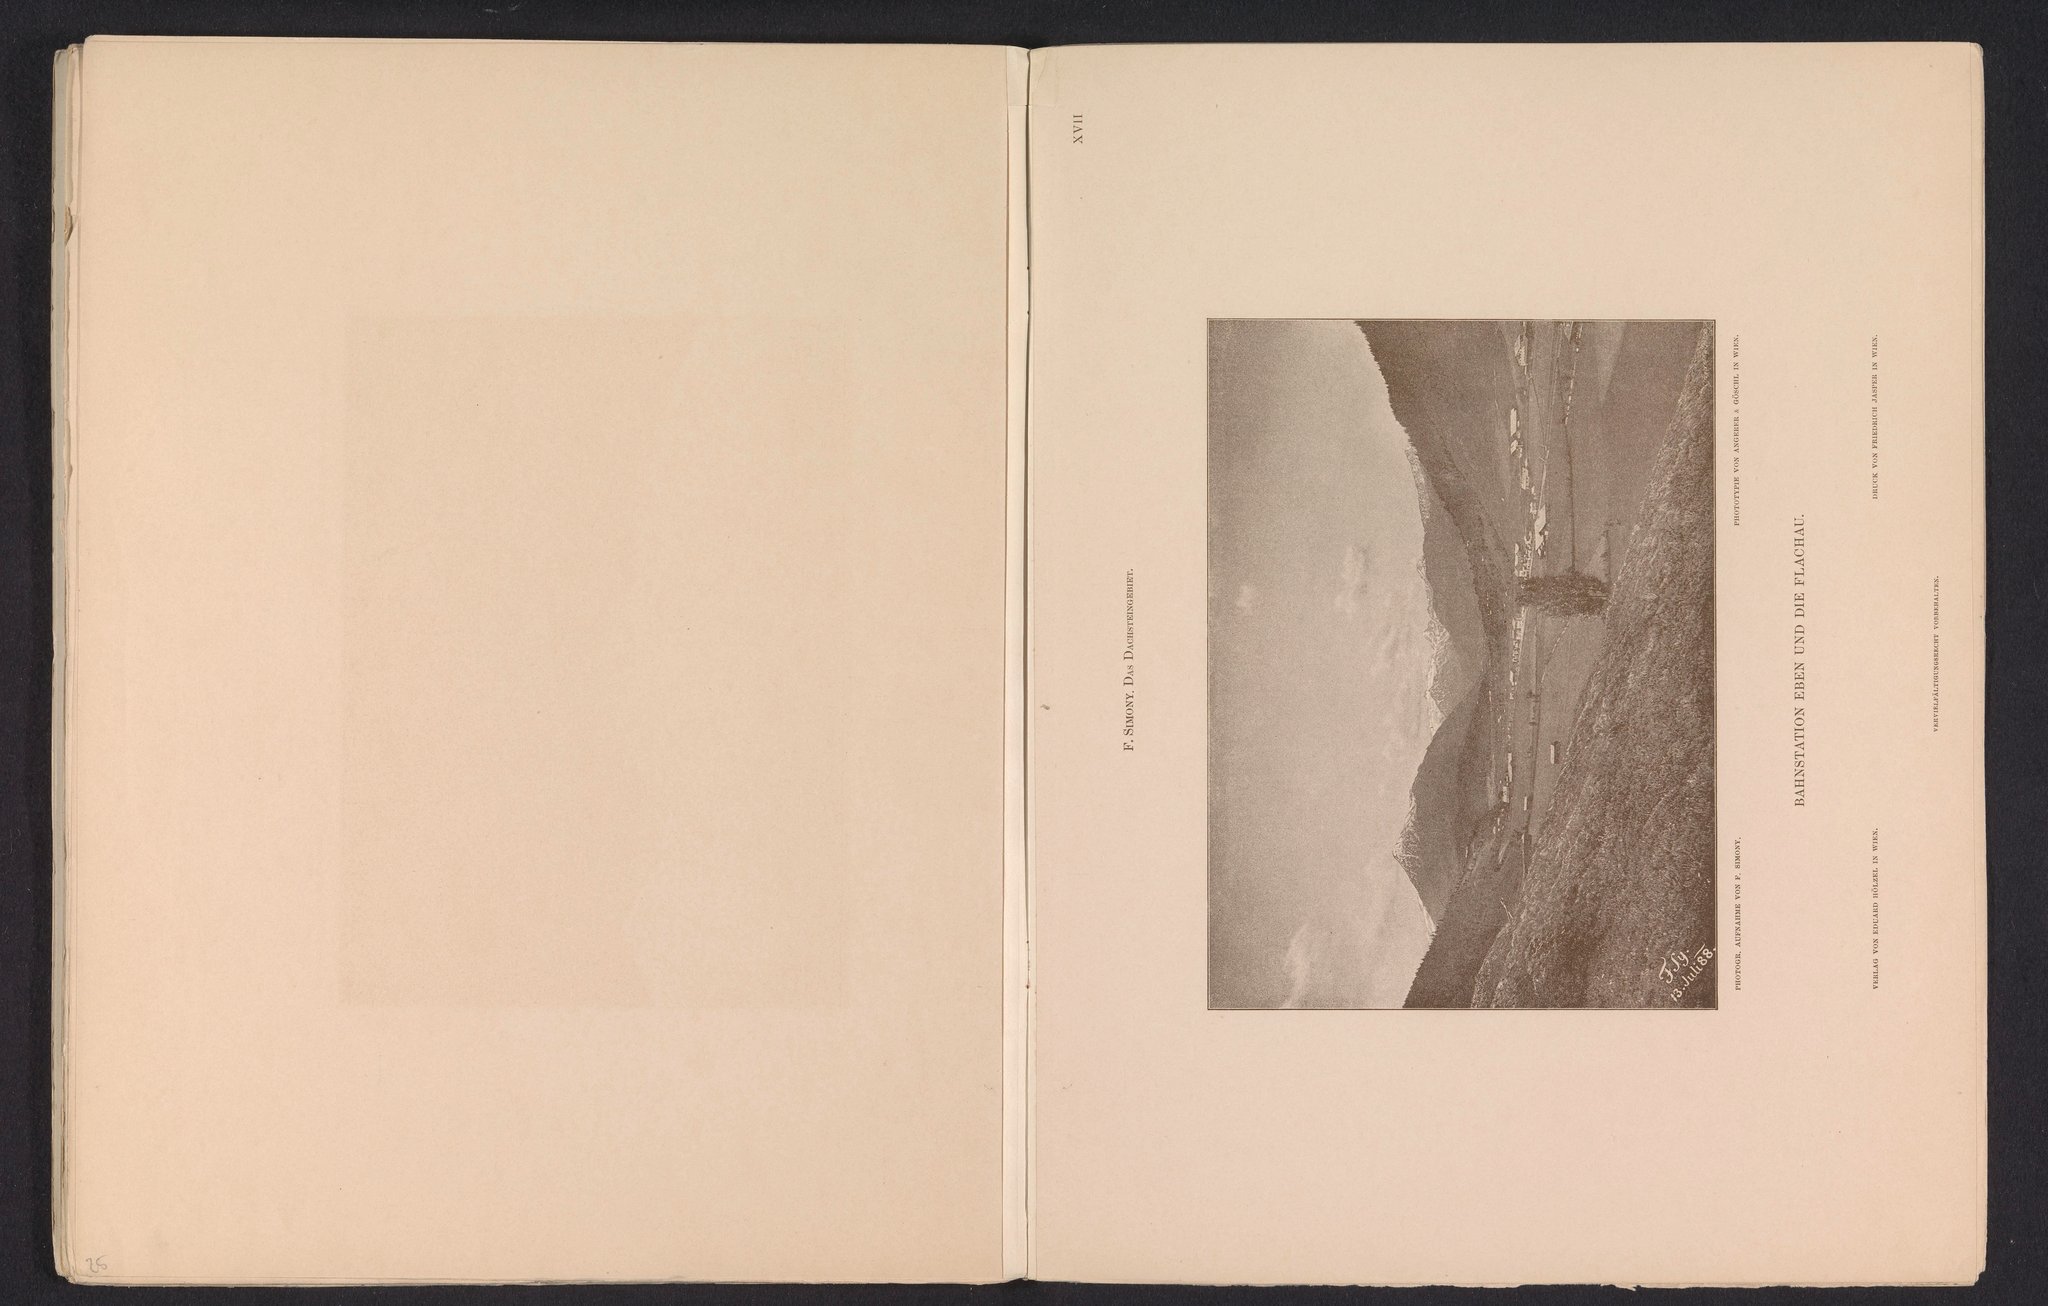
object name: page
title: Gezicht op Flachau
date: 1888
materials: paper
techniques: autotype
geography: vienna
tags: city-view in general; 'veduta'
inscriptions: number: ‘XVII.’